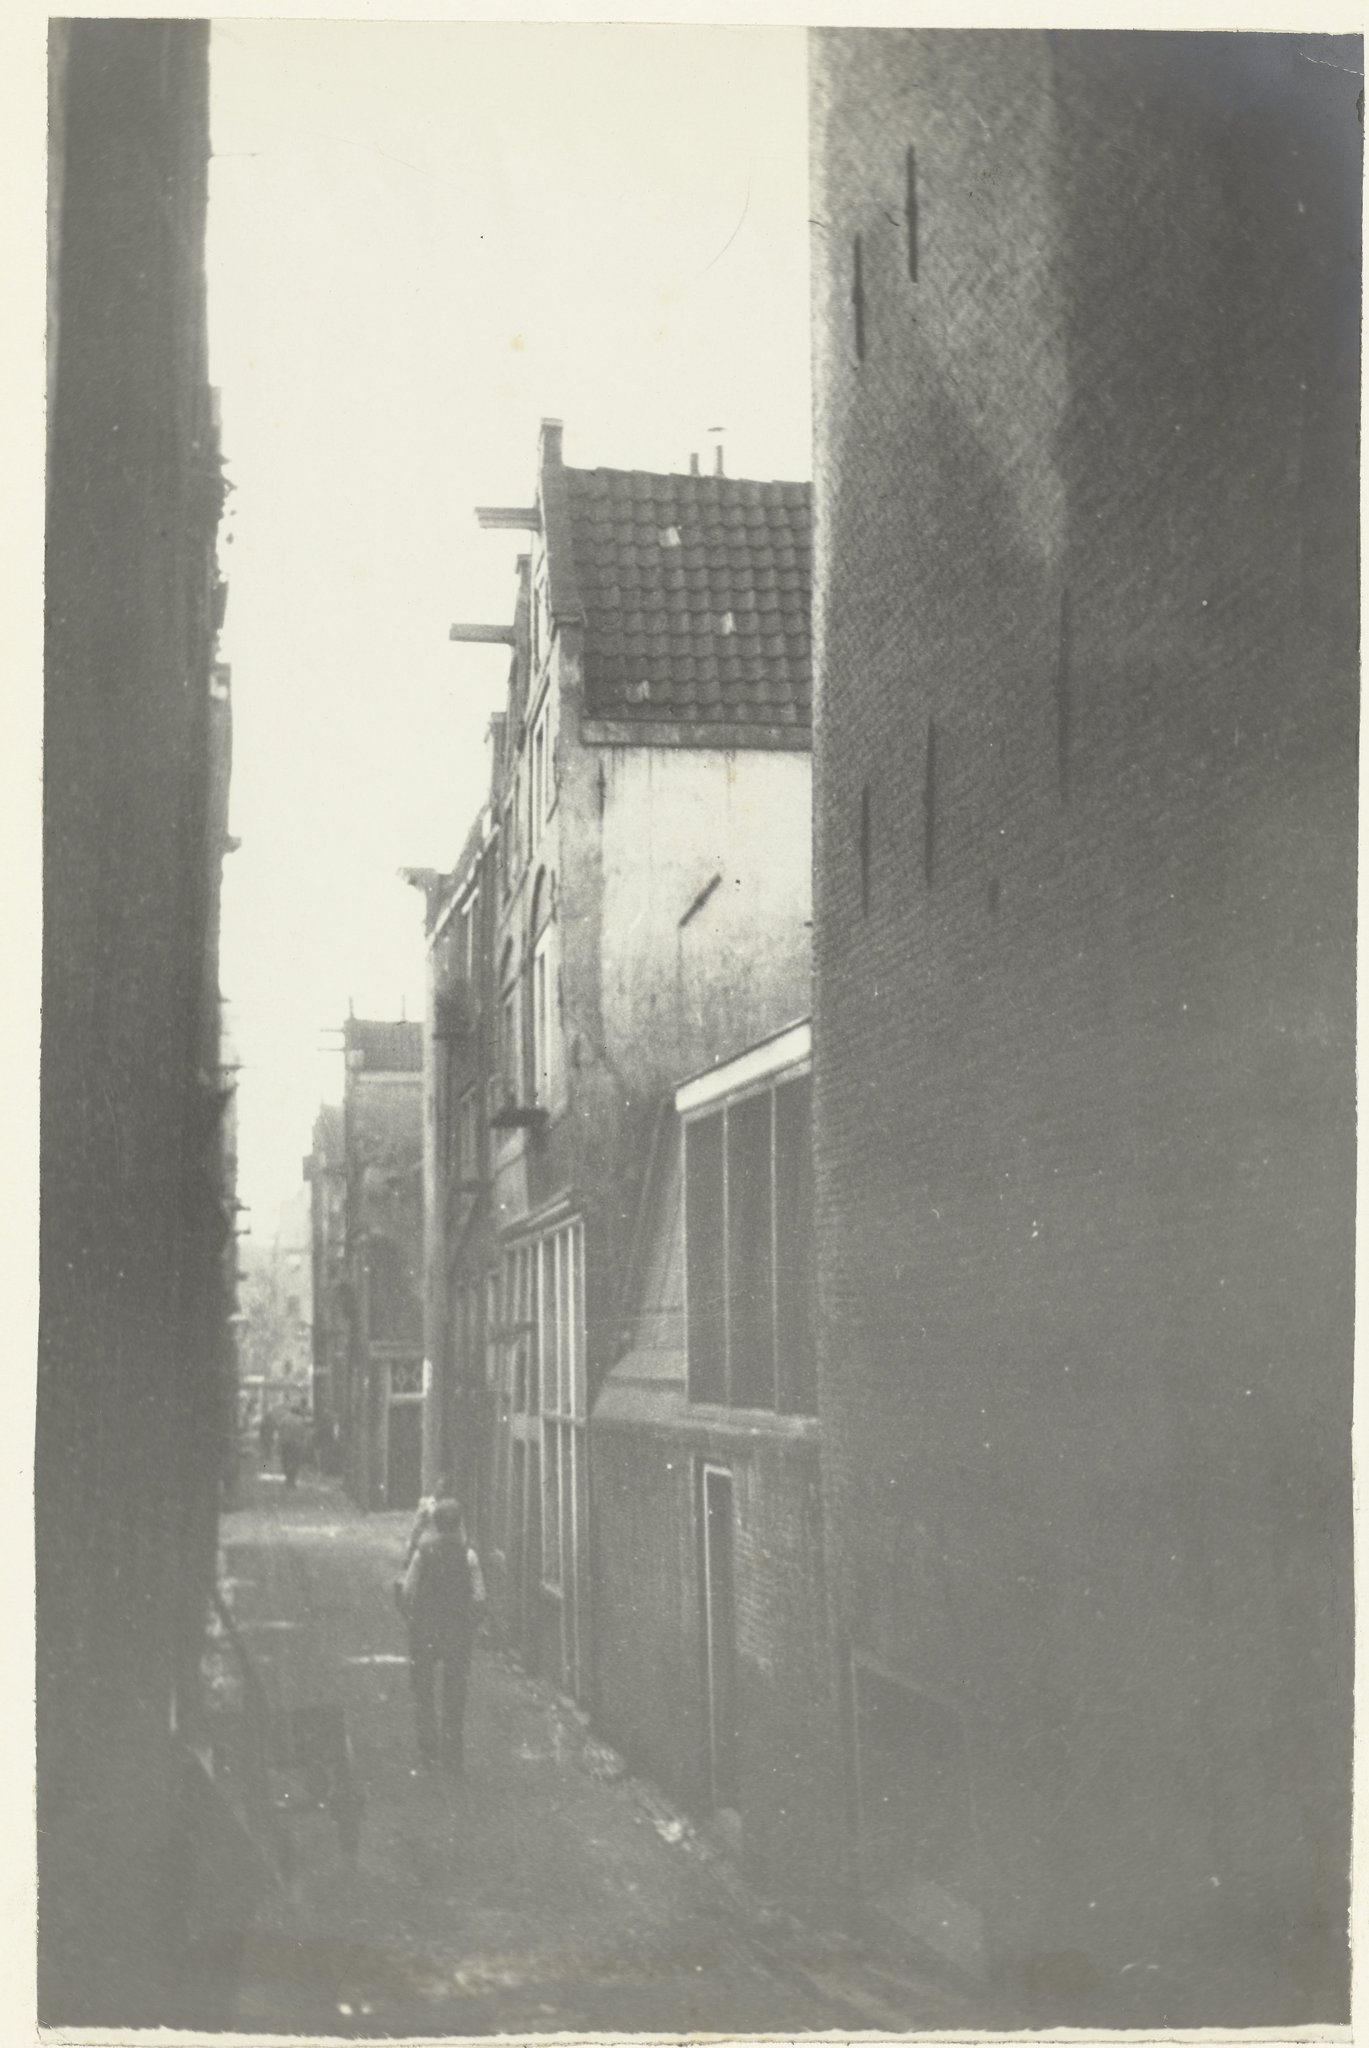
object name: photograph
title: Gezicht in de Baanbrugsteeg te Amsterdam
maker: george hendrik breitner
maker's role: draughtsman, painter, print maker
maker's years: 1857-1923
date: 1886-1910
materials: cardboard, paper, photographic support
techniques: gelatin silver print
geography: amsterdam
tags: street